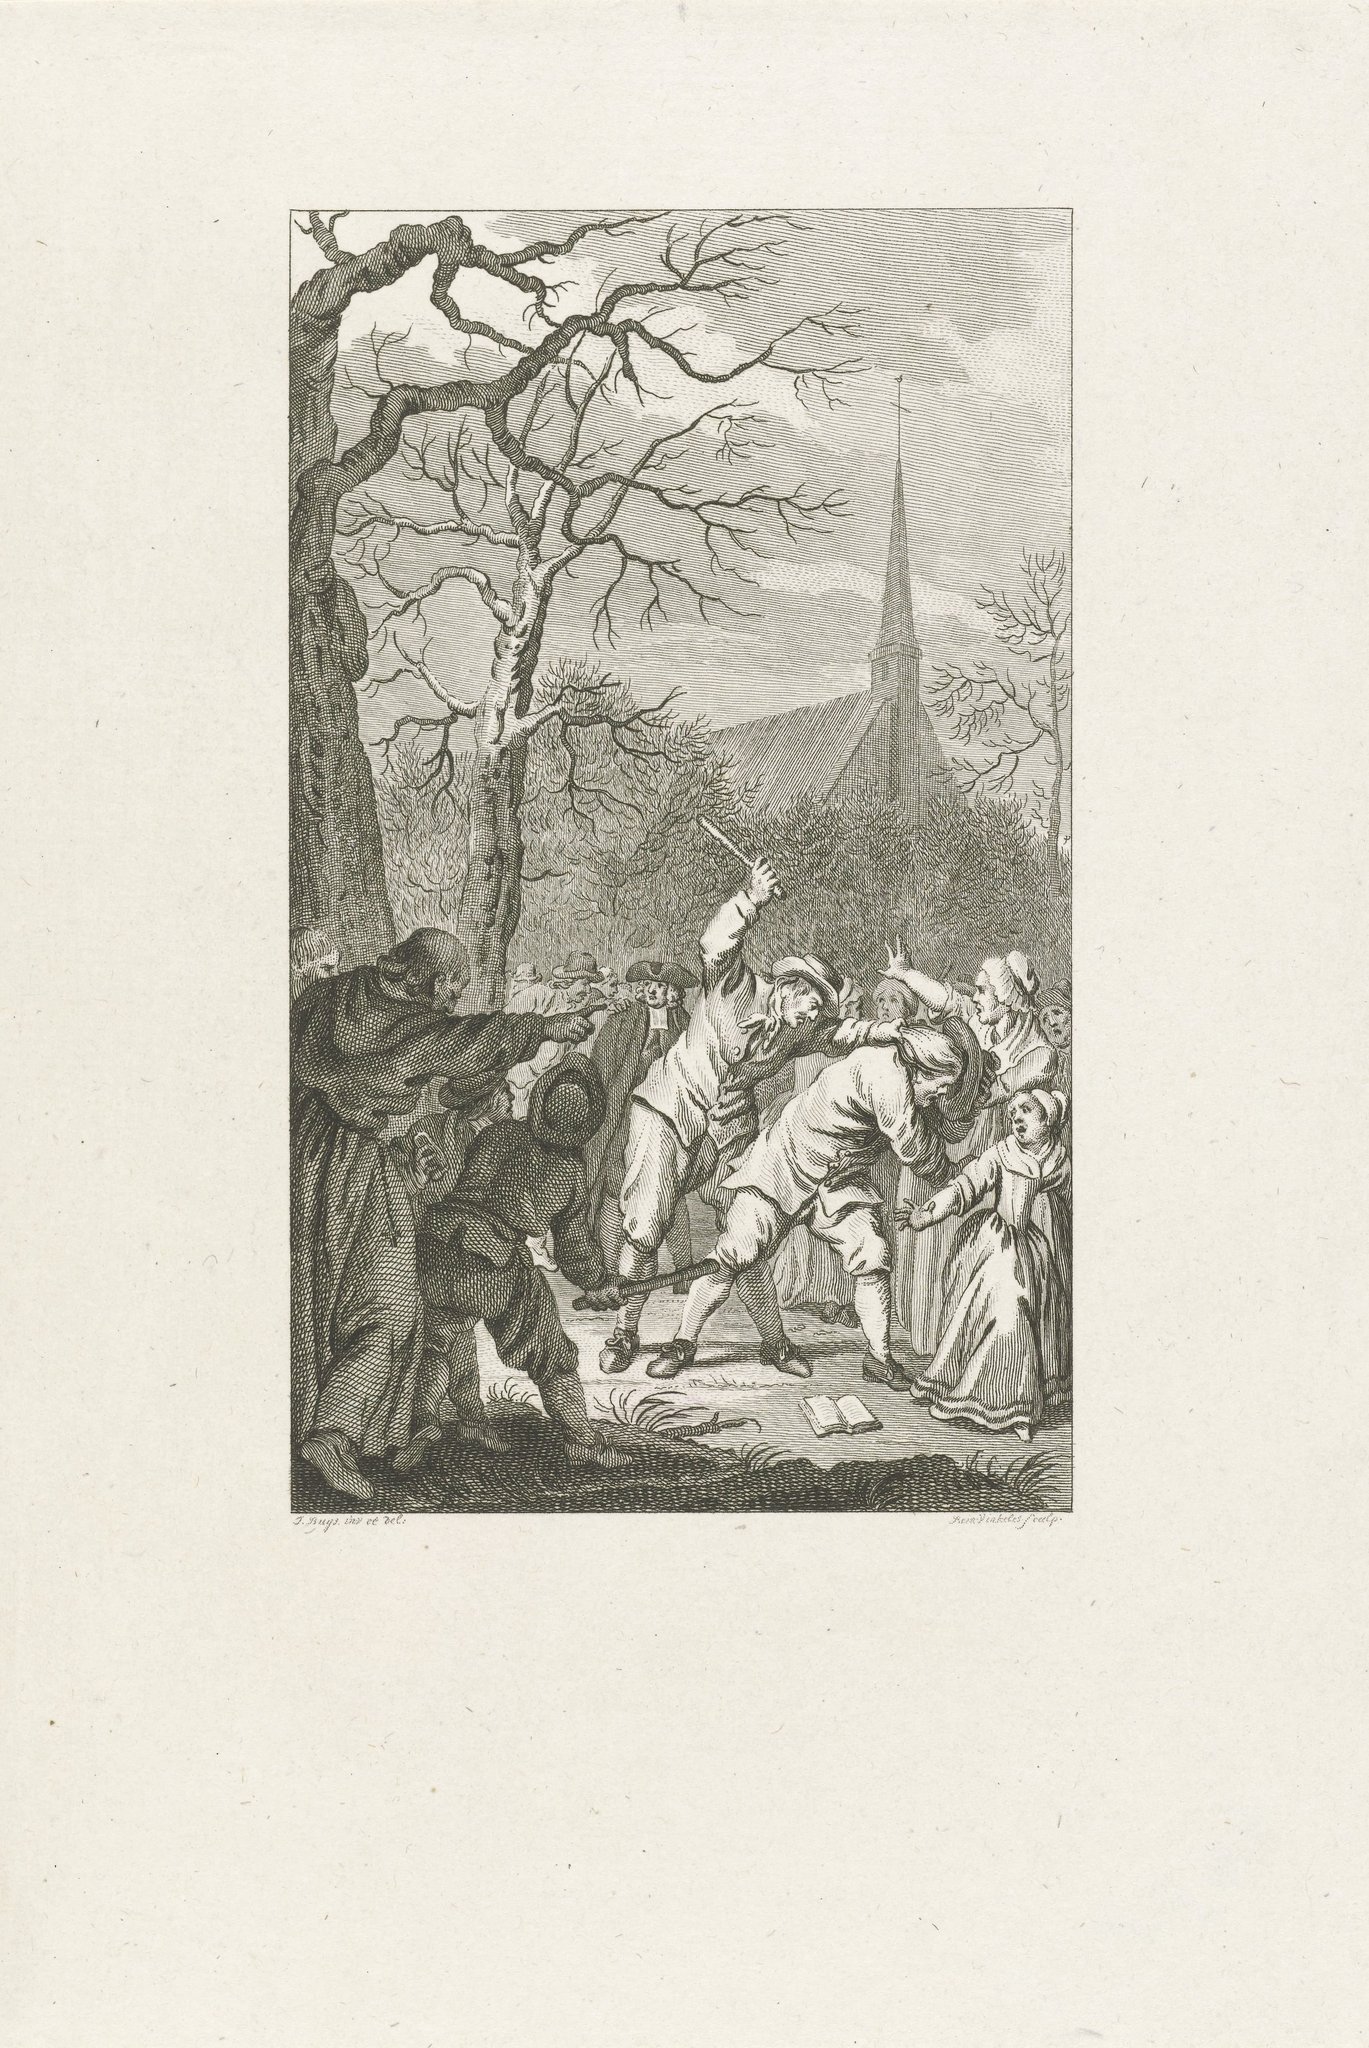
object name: history print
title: Mishandeling van gereformeerden bij Vaals, 1764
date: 1793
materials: paper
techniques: engraving, etching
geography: northern netherlands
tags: persecution of believers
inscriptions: collector's mark: Lugt 2228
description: Mishandeling van gereformeerden door katholieken te Vaals en in drie andere nabij gelegen dorpen, januari 1764. Een roomse priester moedigt aan tot de mishandeling.